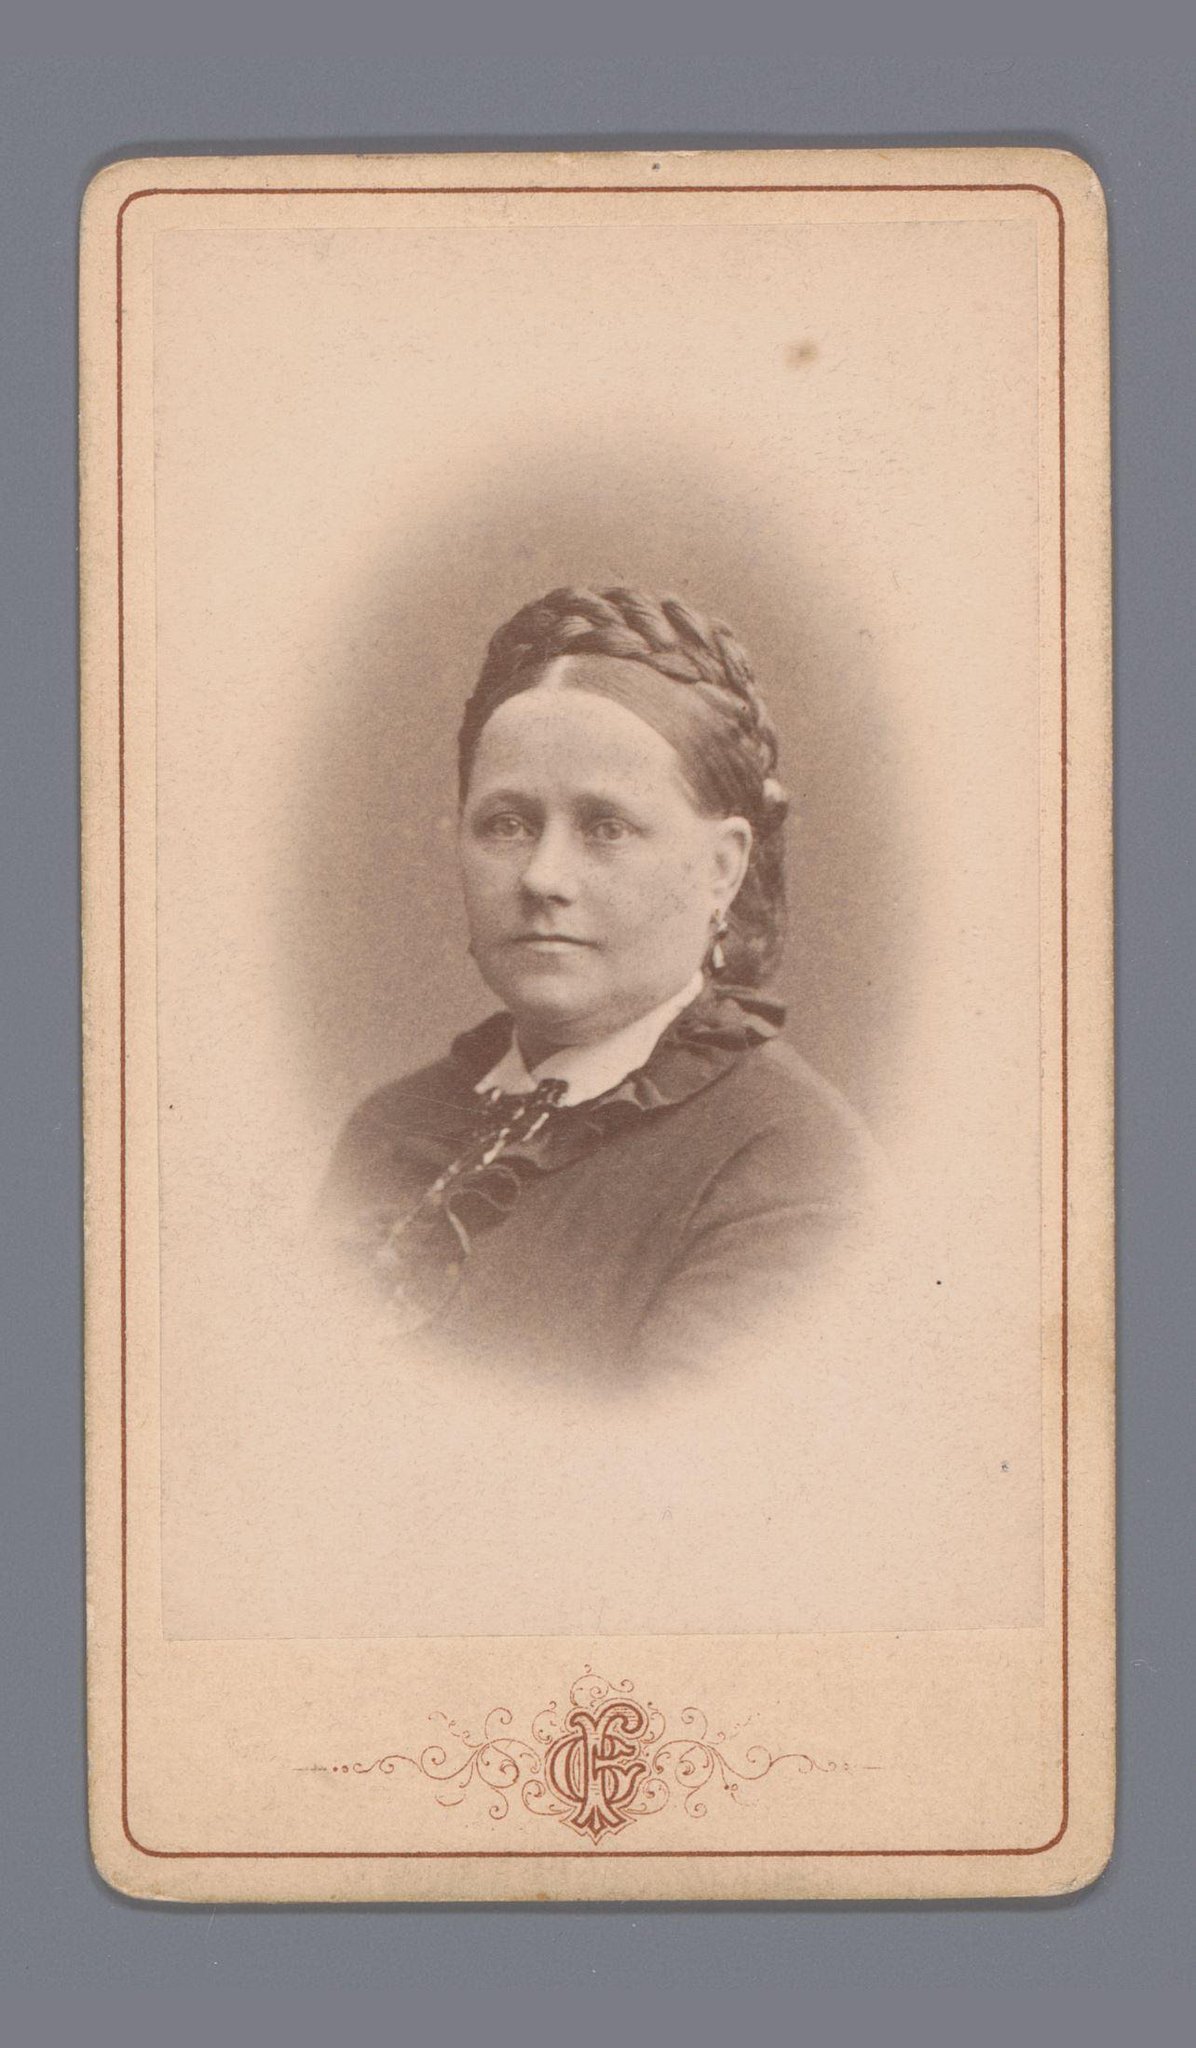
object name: carte de visite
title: Portret van een onbekende vrouw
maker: gösta florman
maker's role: fotograaf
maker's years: 1831-1900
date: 1872-1880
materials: cardboard, paper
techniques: albumen print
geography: stockholm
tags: historical persons - bb - woman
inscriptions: address: ‘STOCKHOLM/ 28A Regeringsgatan 28A/ Odeon.’